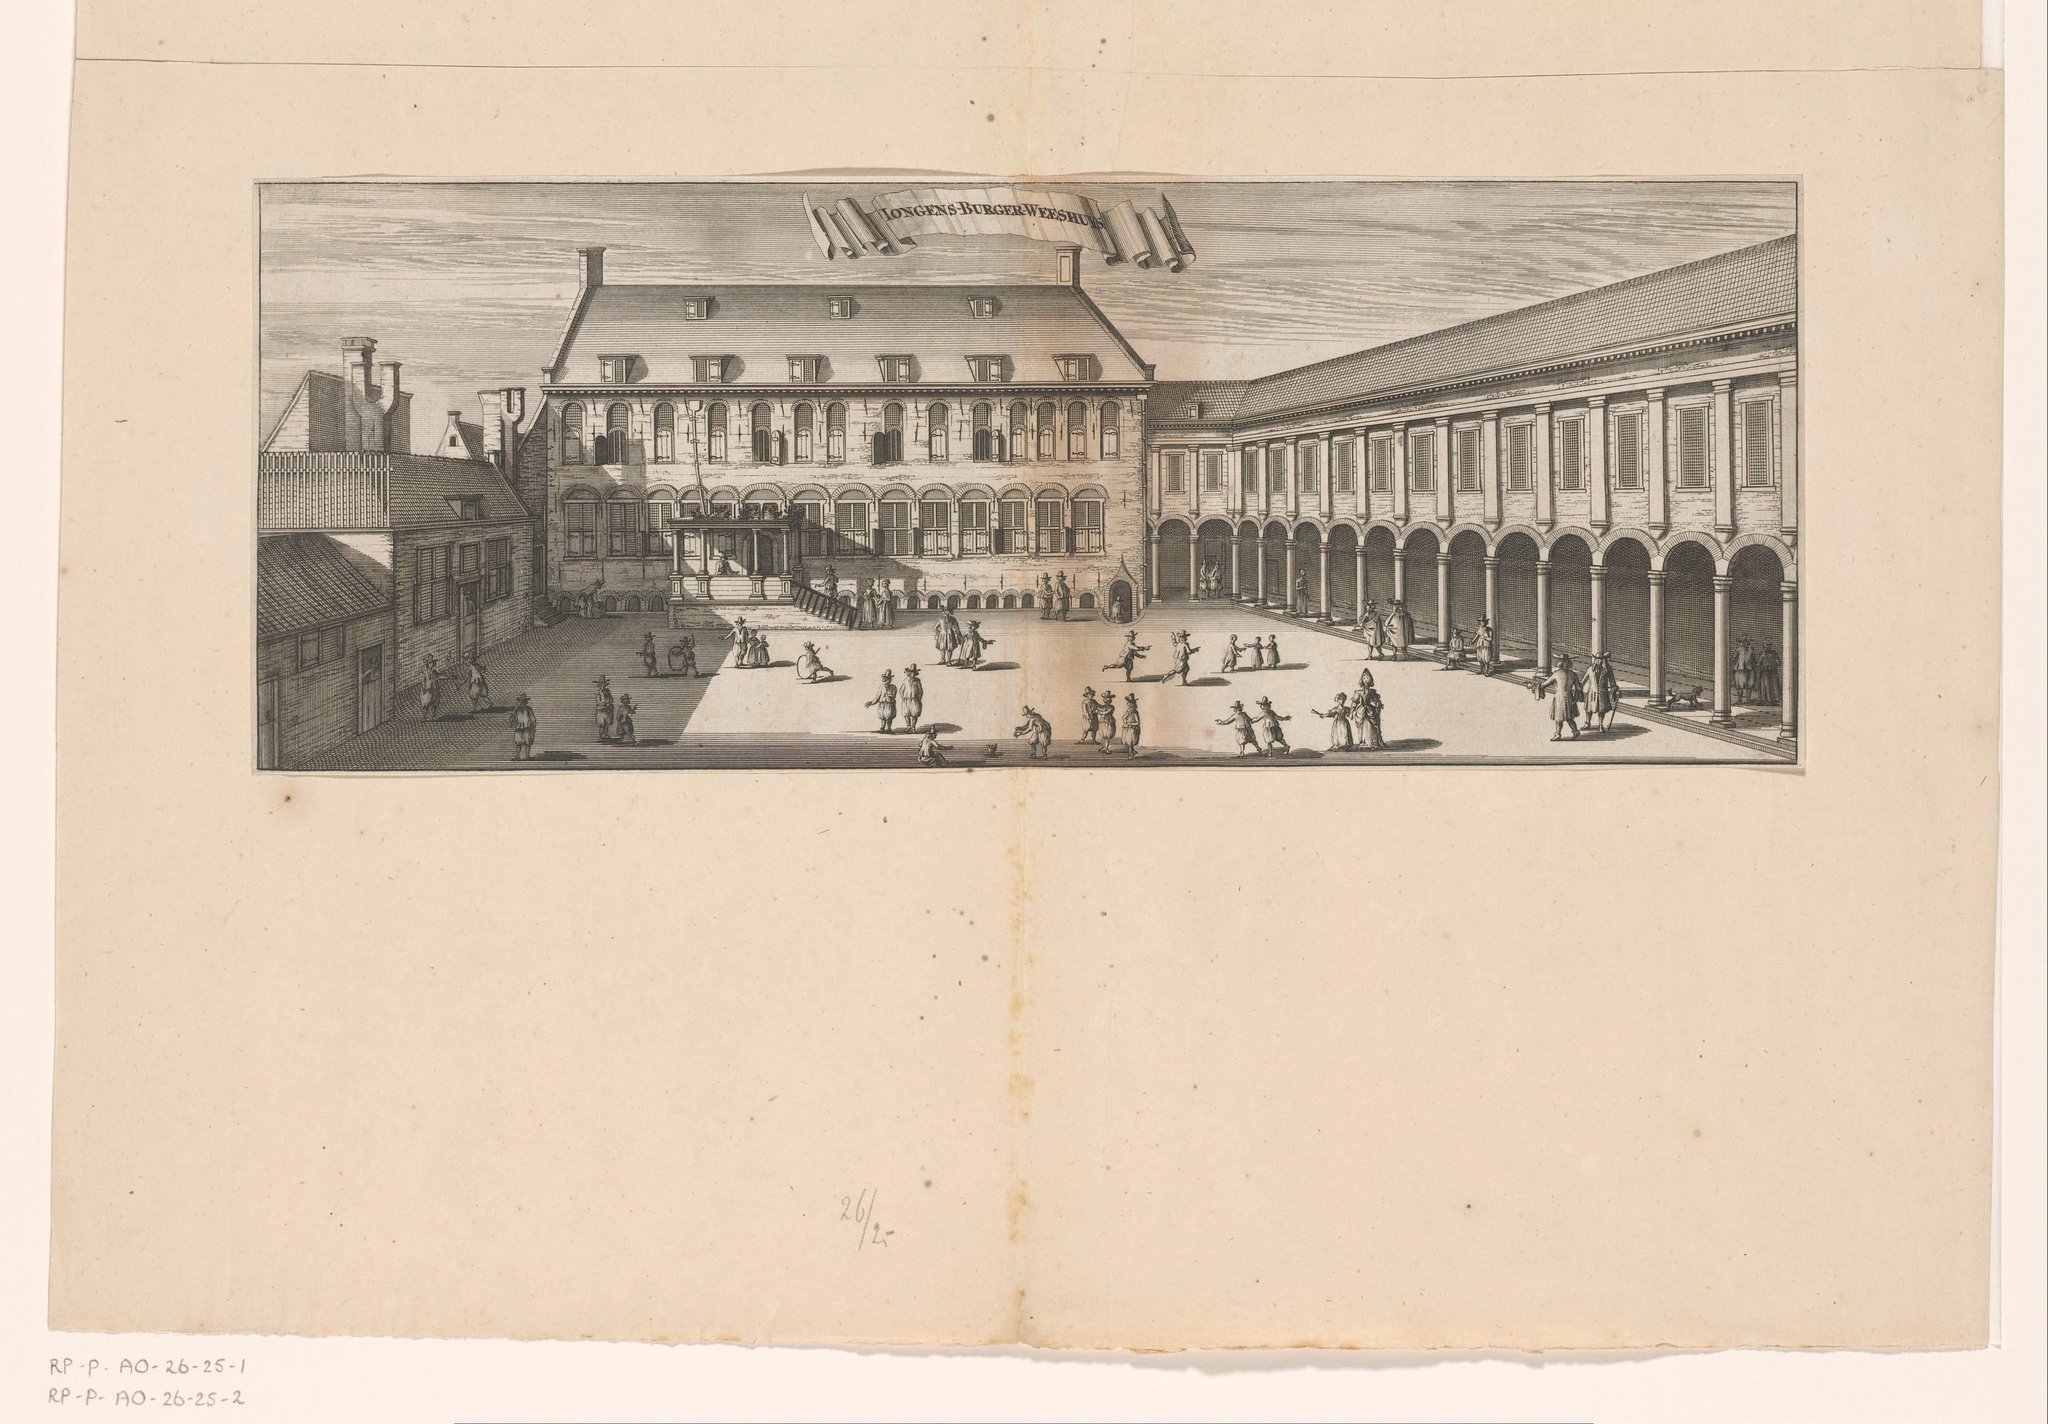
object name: print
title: Iongens-Burger-Weeshuys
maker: Anonymous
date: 1693-1694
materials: paper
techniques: engraving, etching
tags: public welfare, courtyard, orphanage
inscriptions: collector's mark: Lugt 195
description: Huidige staat van prent ook gebruikt in: Commelin, Caspar. Beschryvinge van Amsterdam, desselfs eerste oorspronk uyt den Huyse (…). 2 delen. Amsterdam: Abraham Wolfgang, Gillis Janssonius van Waesberge, Johannes Janssonius van Waesberge II, weduwe Dirk Boom I, Hendrick Boom en Rembertus Goethals, 1693. En in: Commelin, Caspar. Beschryvinge van Amsterdam, zynde een naukeurige verhandelinge van desselfs eerste oorspronk uyt (…). 2 delen. Amsterdam: weduwe Aart Dircksz Oossaan, 1694. Latere staat ook gebruikt in: Commelin, Caspar. Beschryvinge van Amsterdam, zynde een naukeurige verhandelinge van desselfs eerste oorspronk uyt (…). 2 delen. 2e druk. Amsterdam: Andries van Damme, Johannes Ratelband, weduwe A. van Aaltwyk en Hermanus Uytwerf, 1726. Oorspronkelijk van één plaat gedrukt met RP-P-AO-26-26-2.